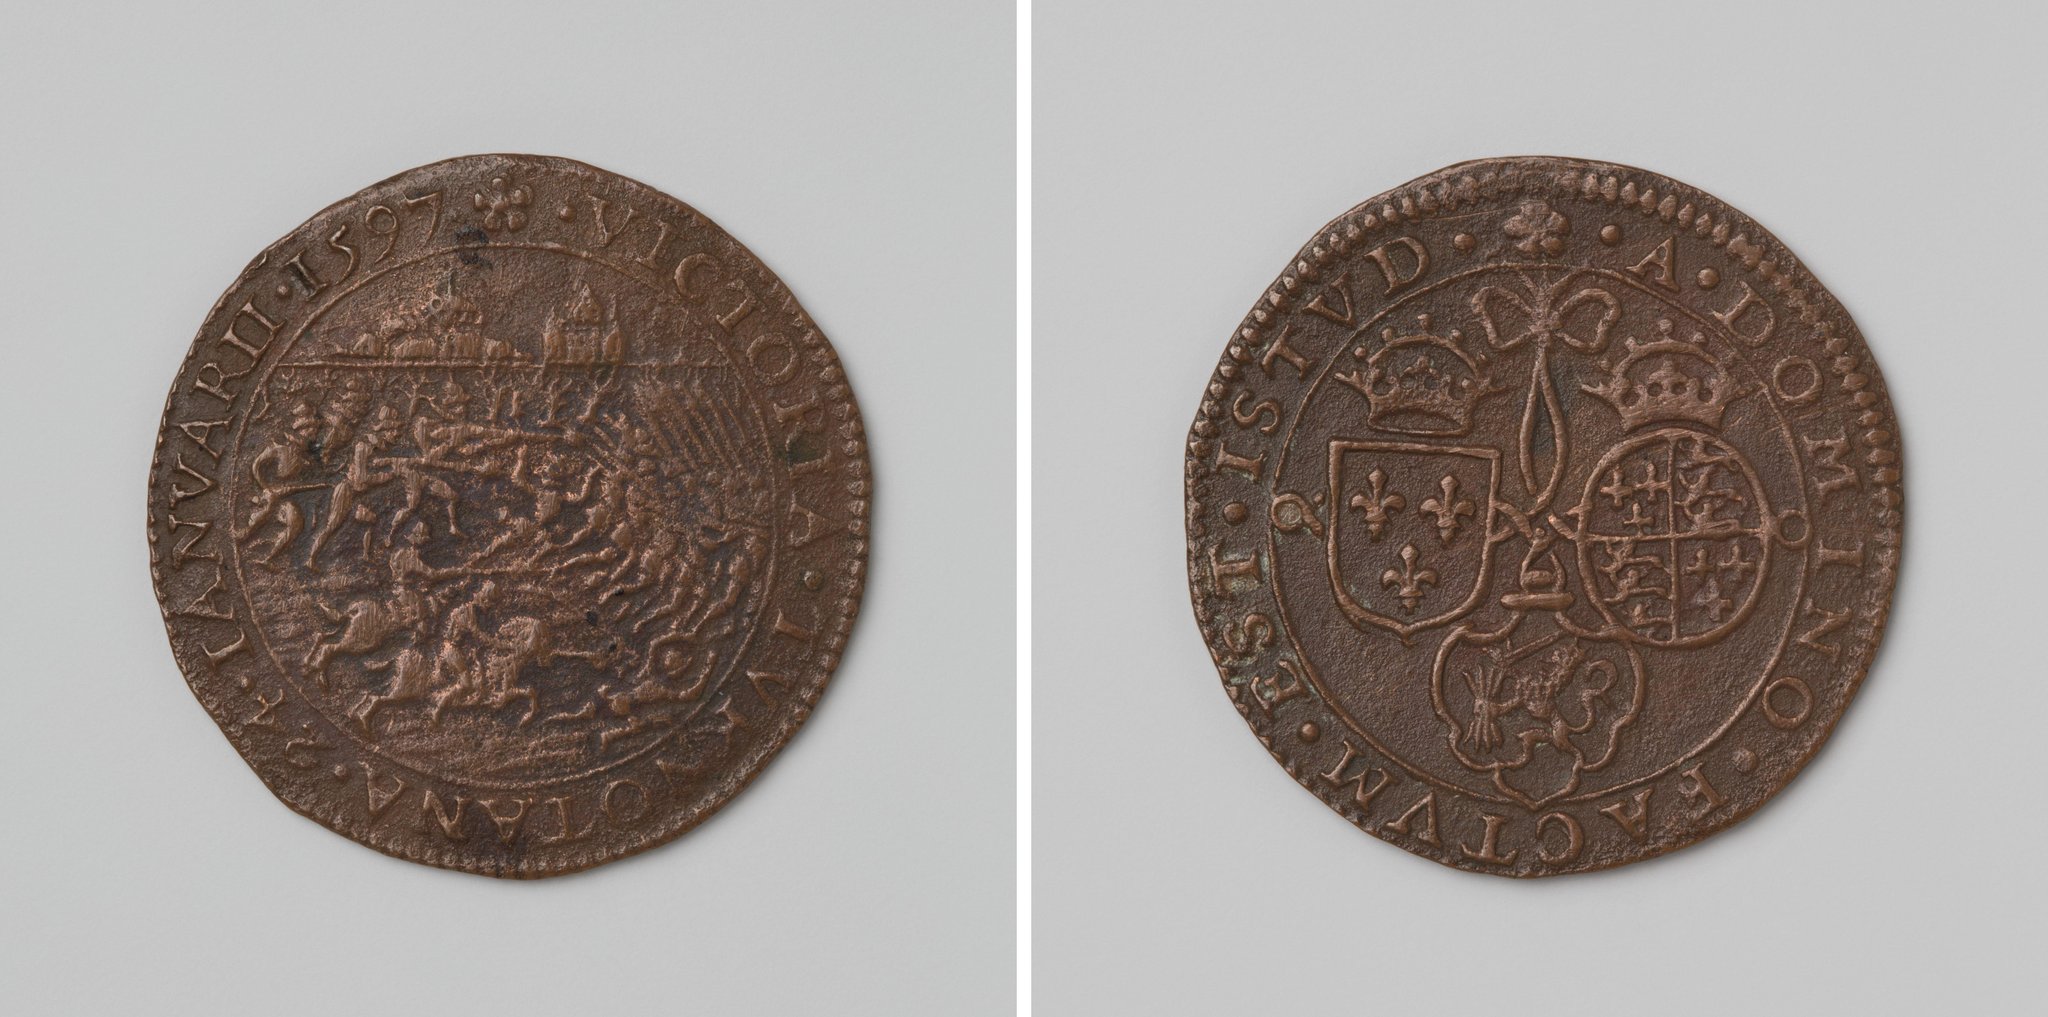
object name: jeton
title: Overwinning in de slag bij Turnhout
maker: Anonymous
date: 1597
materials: copper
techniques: striking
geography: dordrecht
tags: turnhout, tachtigjarige oorlog, slag bij turnhout (1597)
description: Koperen penning. Voorzijde: Staatse troepen verjagen de Spanjaarden; op achtergrond gezicht op stad Turnhout binnen omschrift. Keerzijde: drie wapenschilden verbonden door lint binnen omschrift